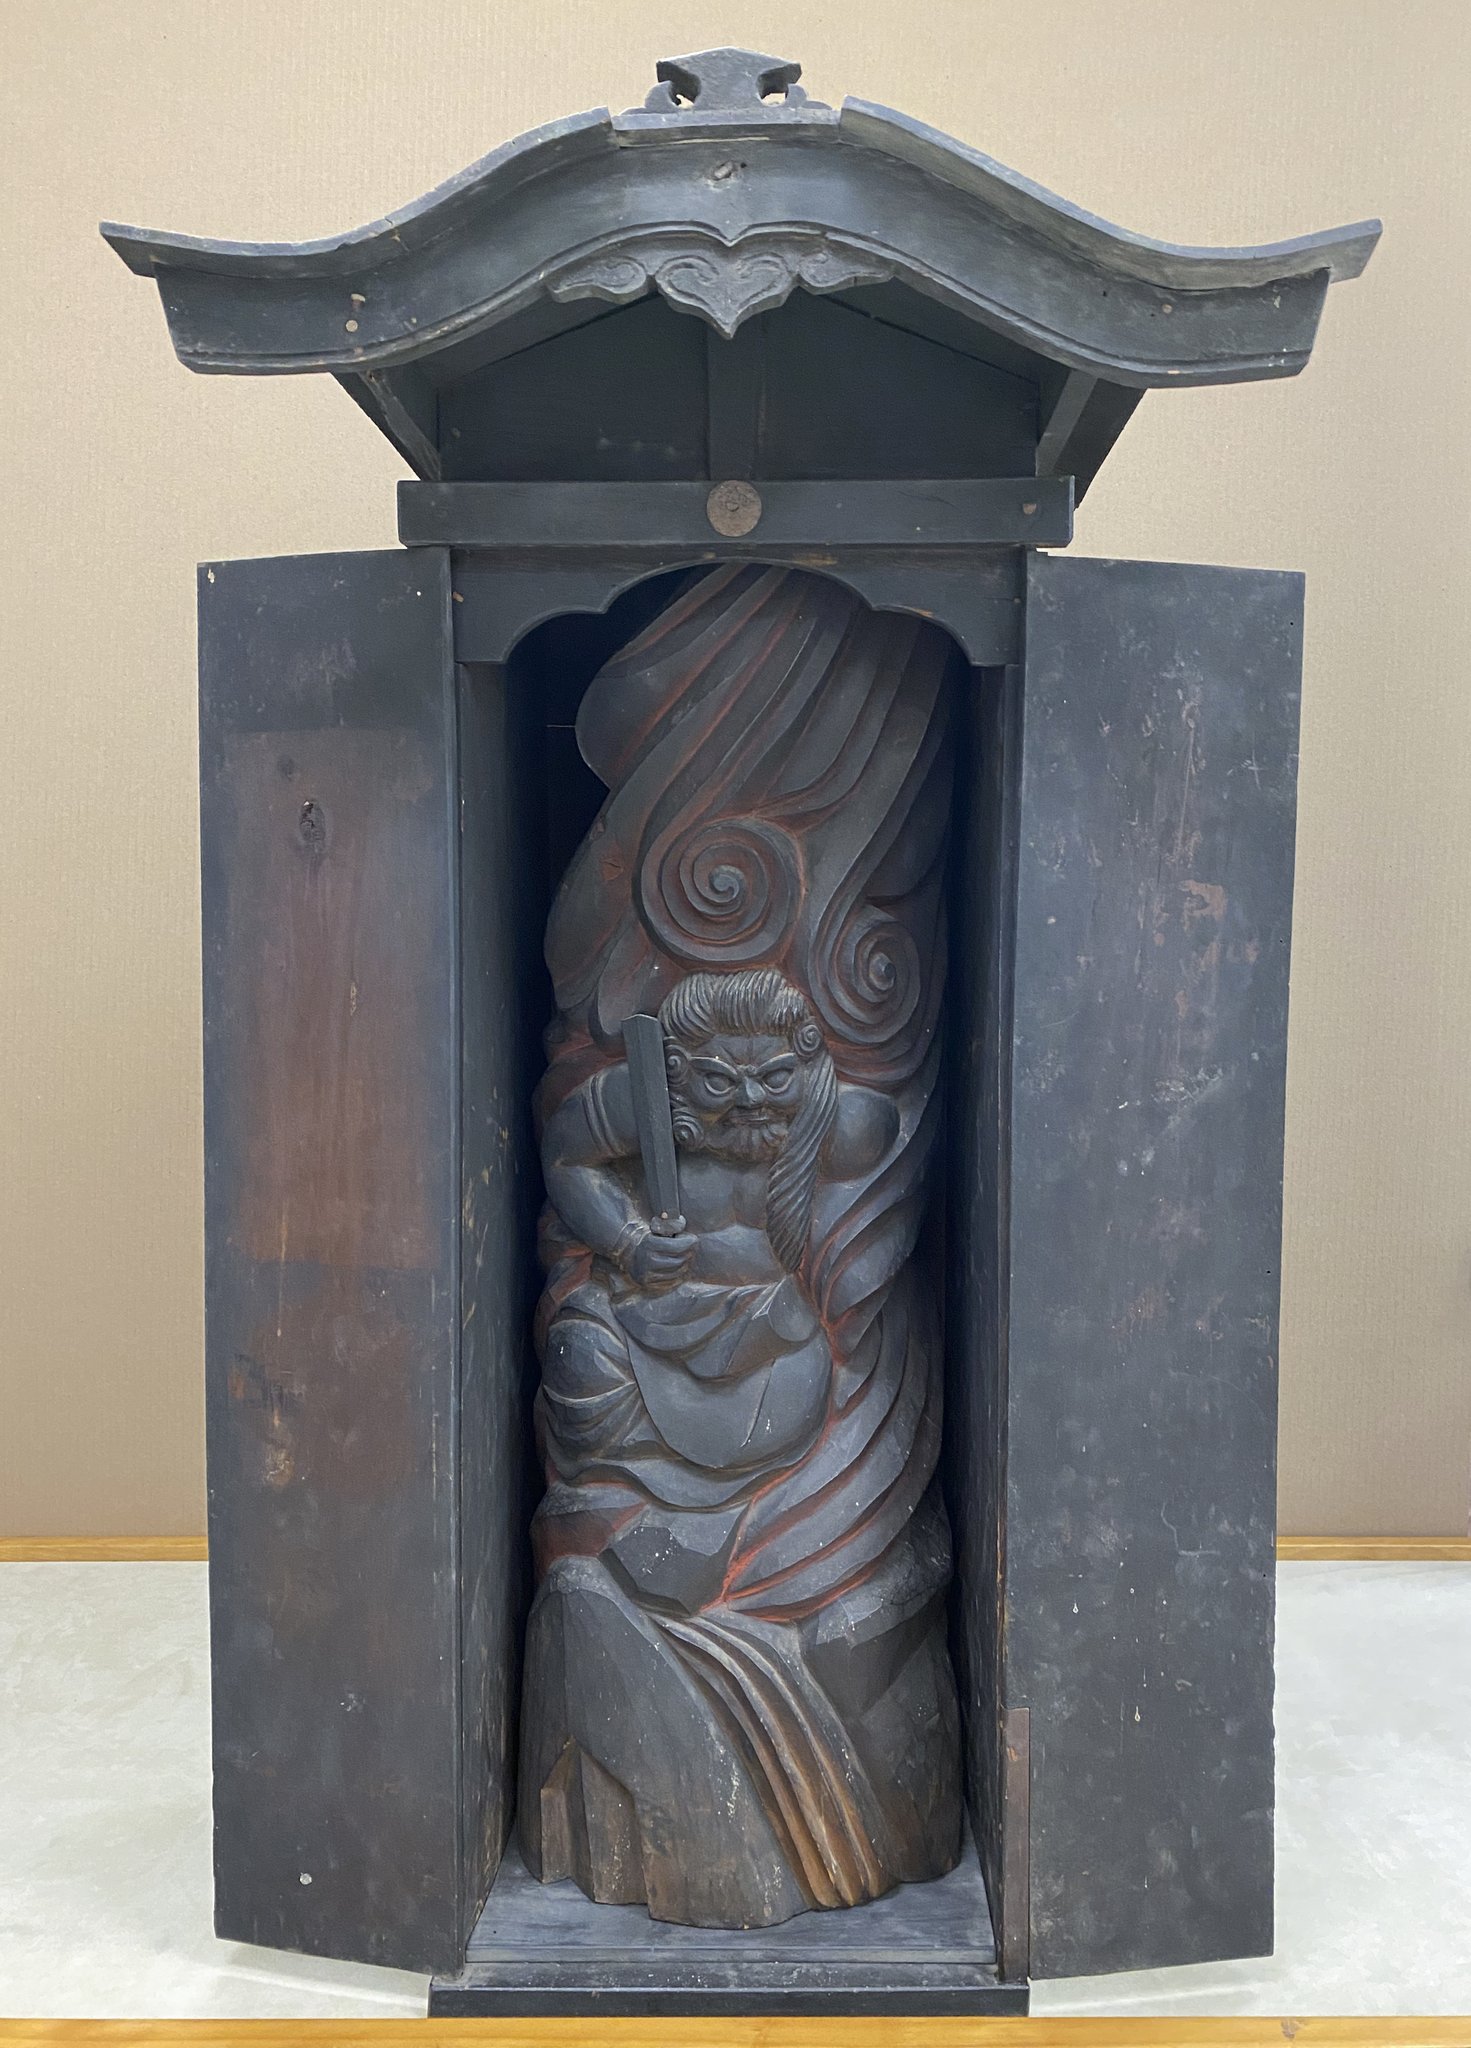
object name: sculpture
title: Altar Cabinet (Zushi) for Fudō Myōō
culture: japanese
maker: unidentified artist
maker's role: artist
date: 1801-1900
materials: wood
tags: altars,cabinets